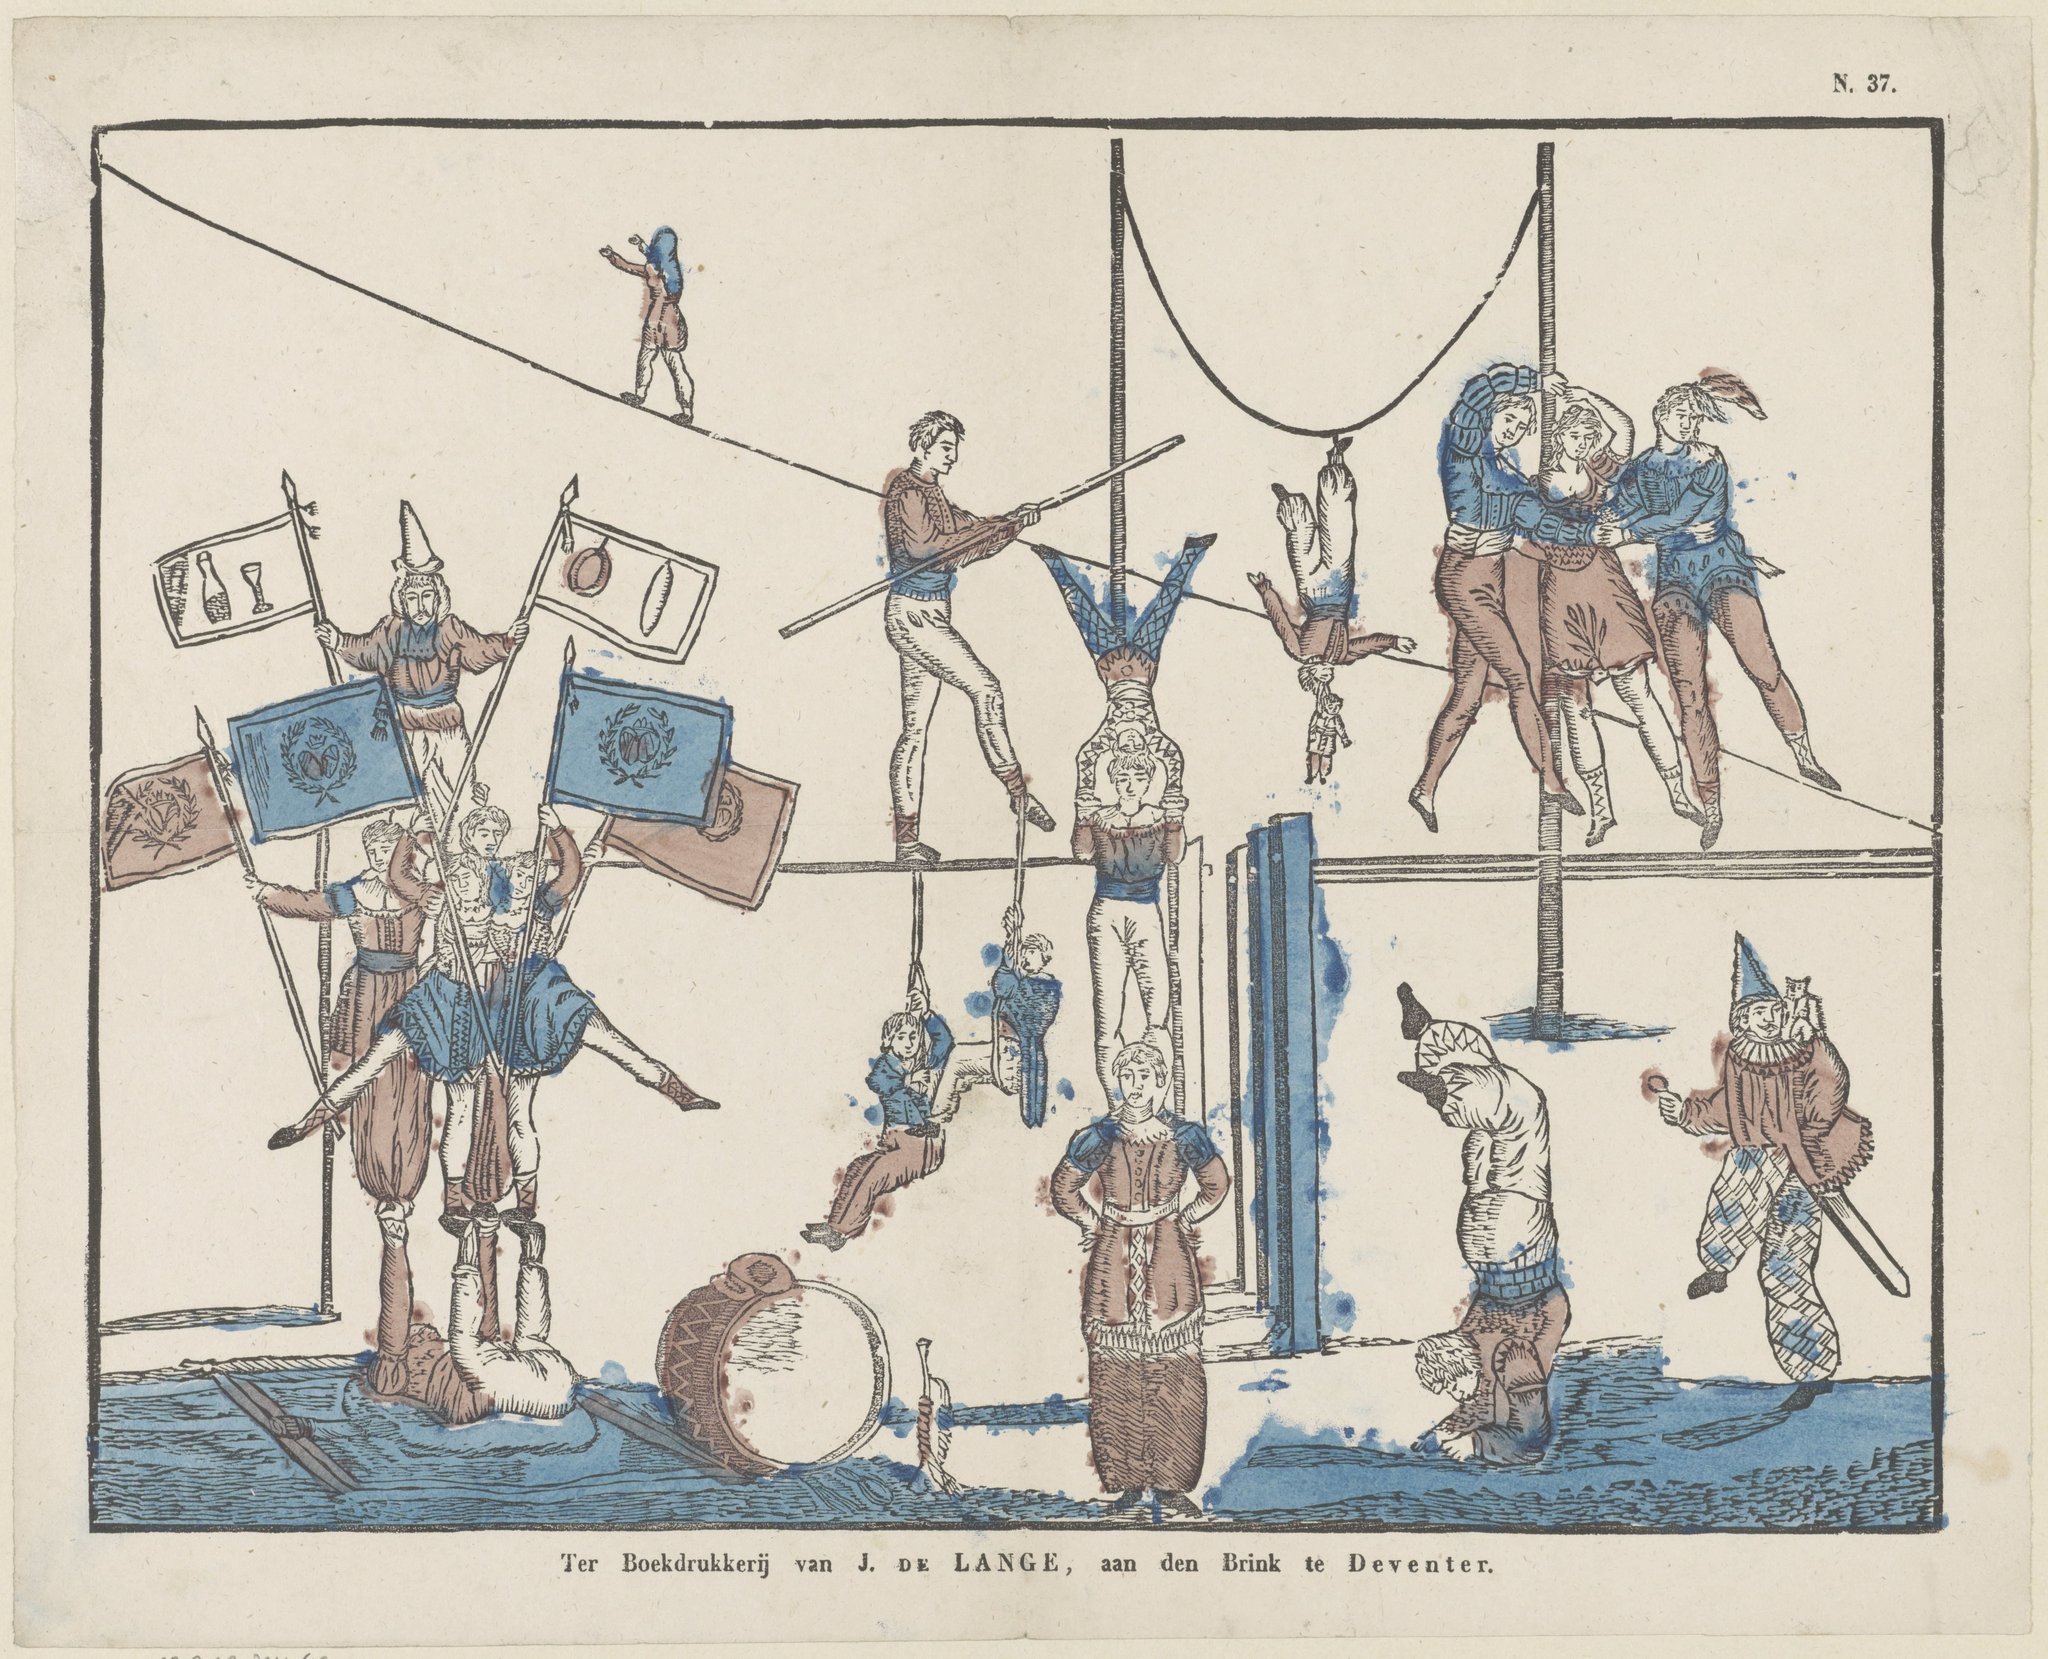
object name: popular print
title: Circustafereel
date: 1822-1849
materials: paper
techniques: colour, letterpress printing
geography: netherlands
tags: musician, acrobat ~ circus, circus, tight-ropewalker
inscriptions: collector's mark: Lugt 2760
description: Een circustafereel met acrobaten, muzikanten en koorddansers. Genummerd rechtsboven: N. 37.